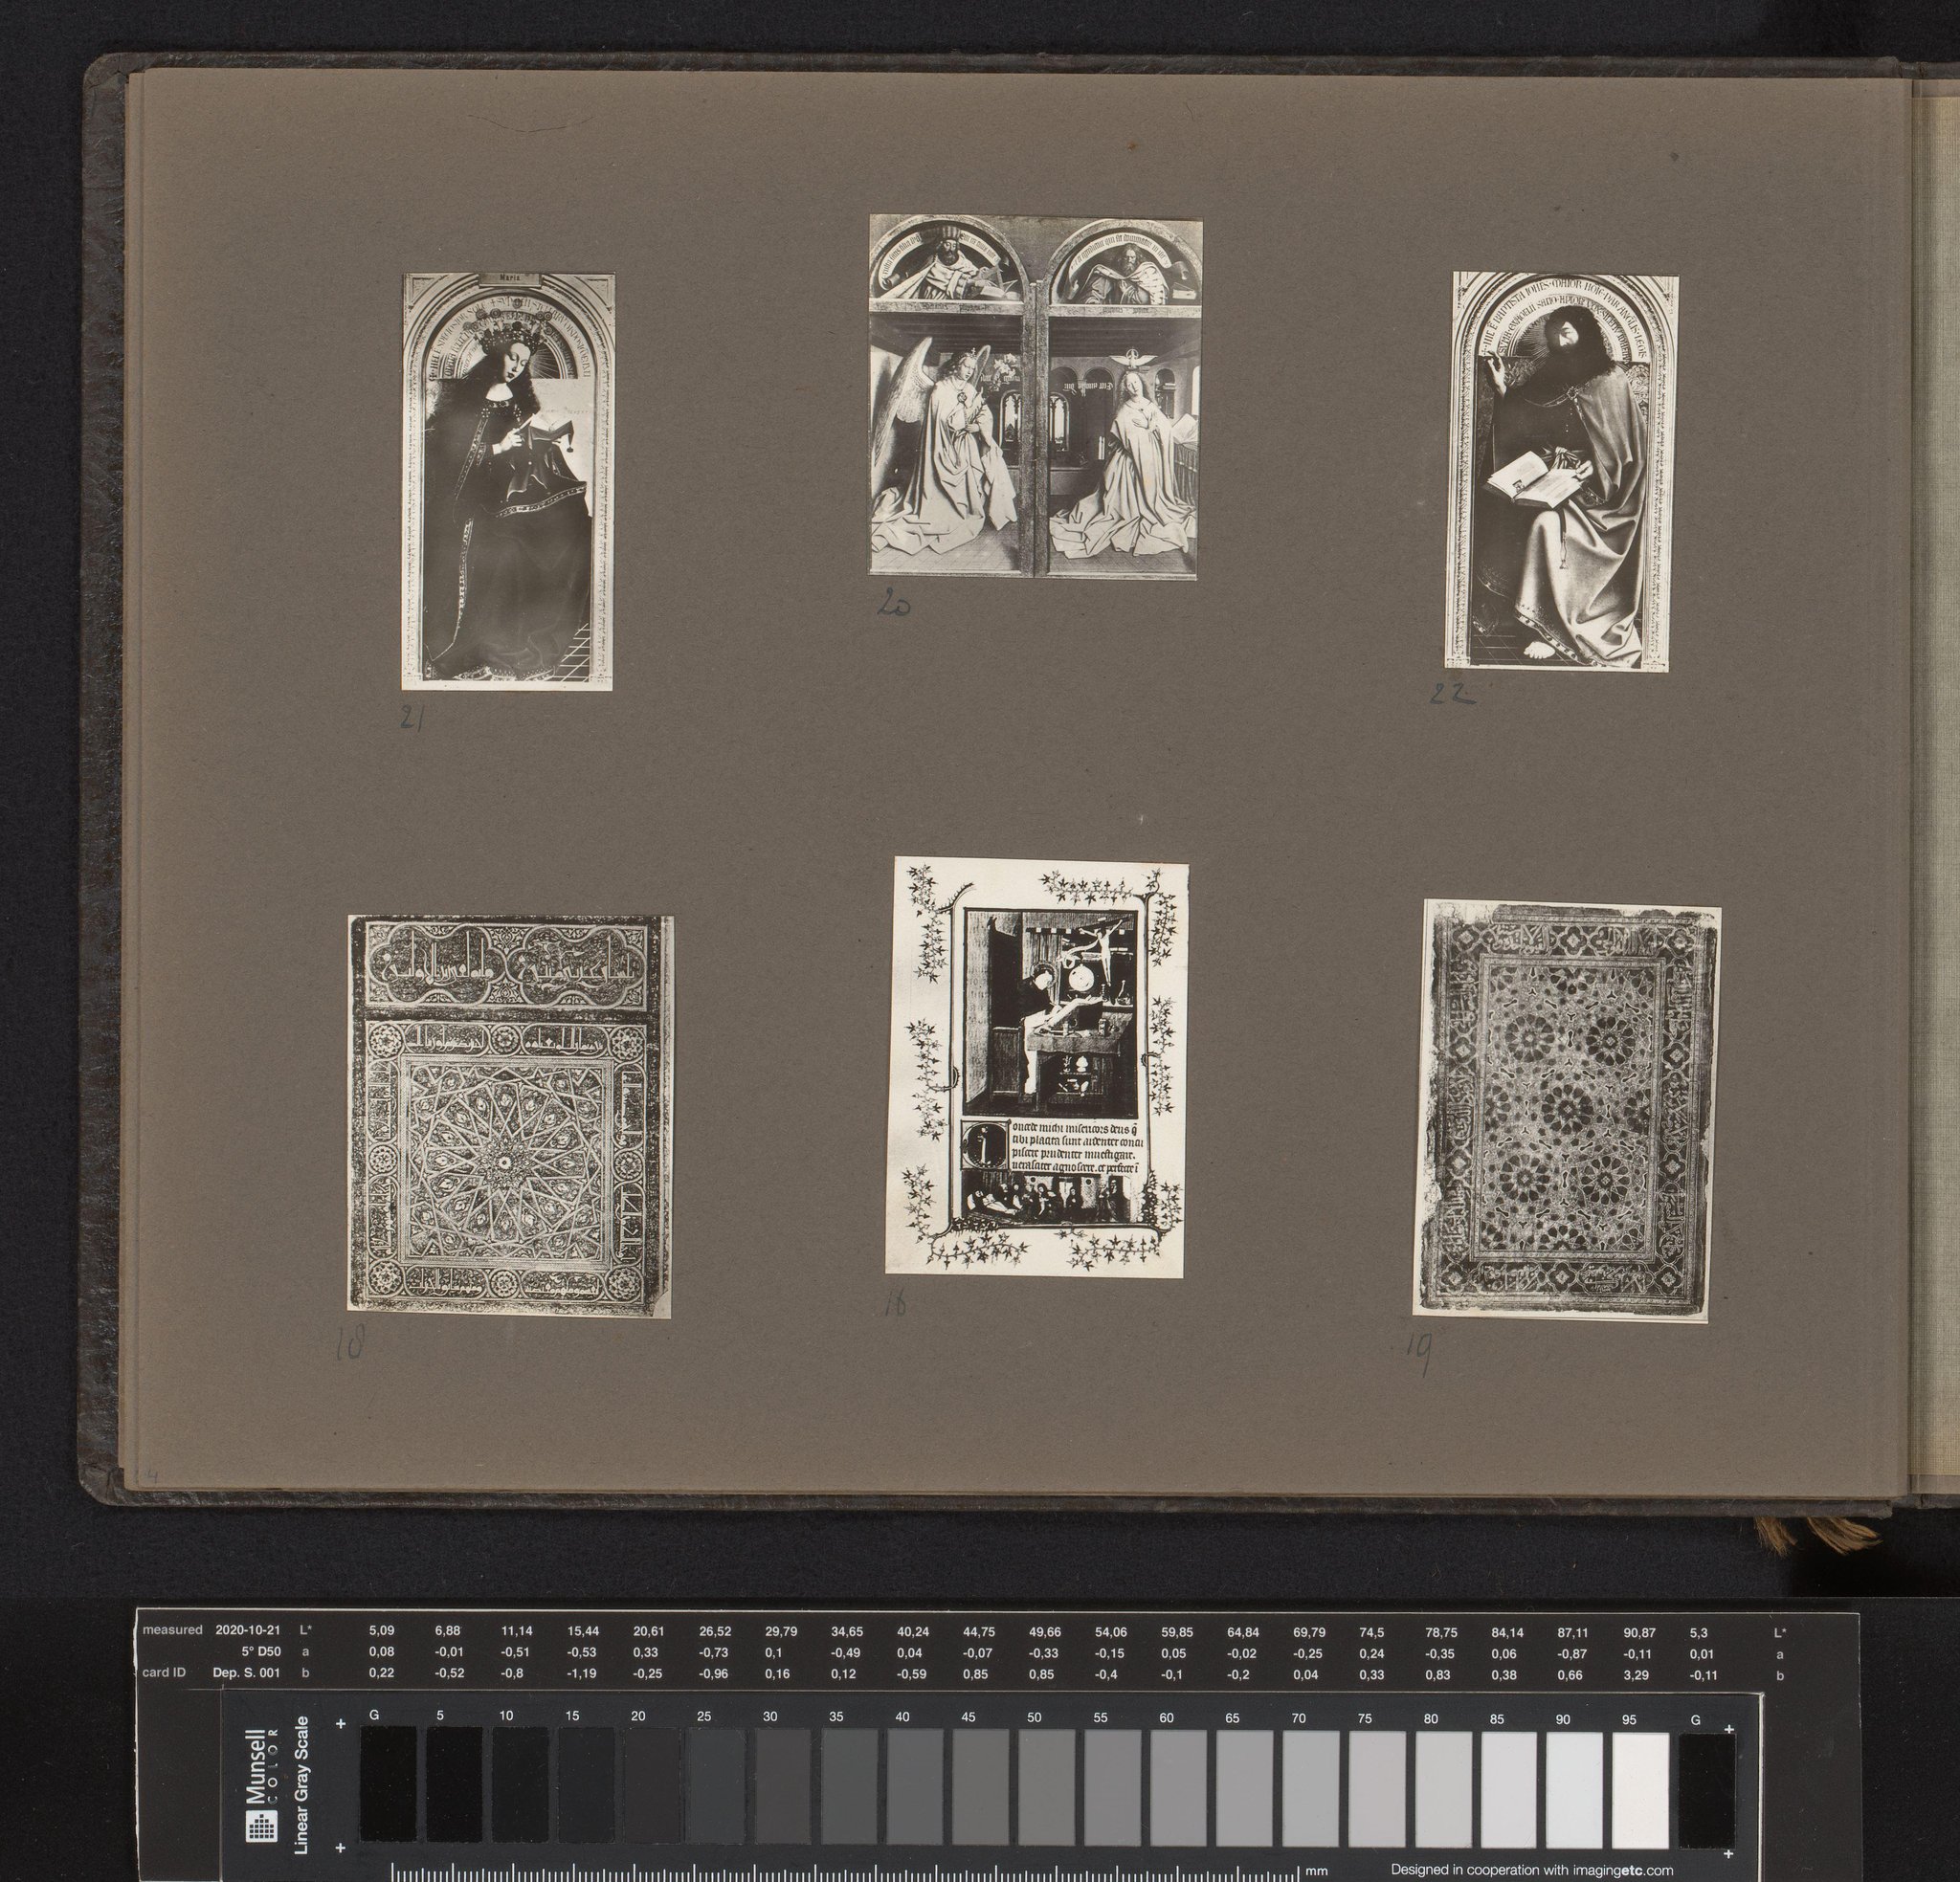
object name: photograph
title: Drie fotoreproducties van schilderijen, twee boekbanden en een titelpagina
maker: Anonymous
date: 1920-1940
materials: paper, photographic support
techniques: gelatin silver print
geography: netherlands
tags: title-page, mary and joseph, book-cover, binding, the annunciation: mary, usually reading, is visited by the angel (sometimes a woman overhears the conversation)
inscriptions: number: ‘21 - 20 - 22/ 18 - 16 - 19’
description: Op de fotoreproducties zijn respectievelijk Maria, de Annunciatie en Jozef afgebeeld. Deze foto's maken deel uit van een album.